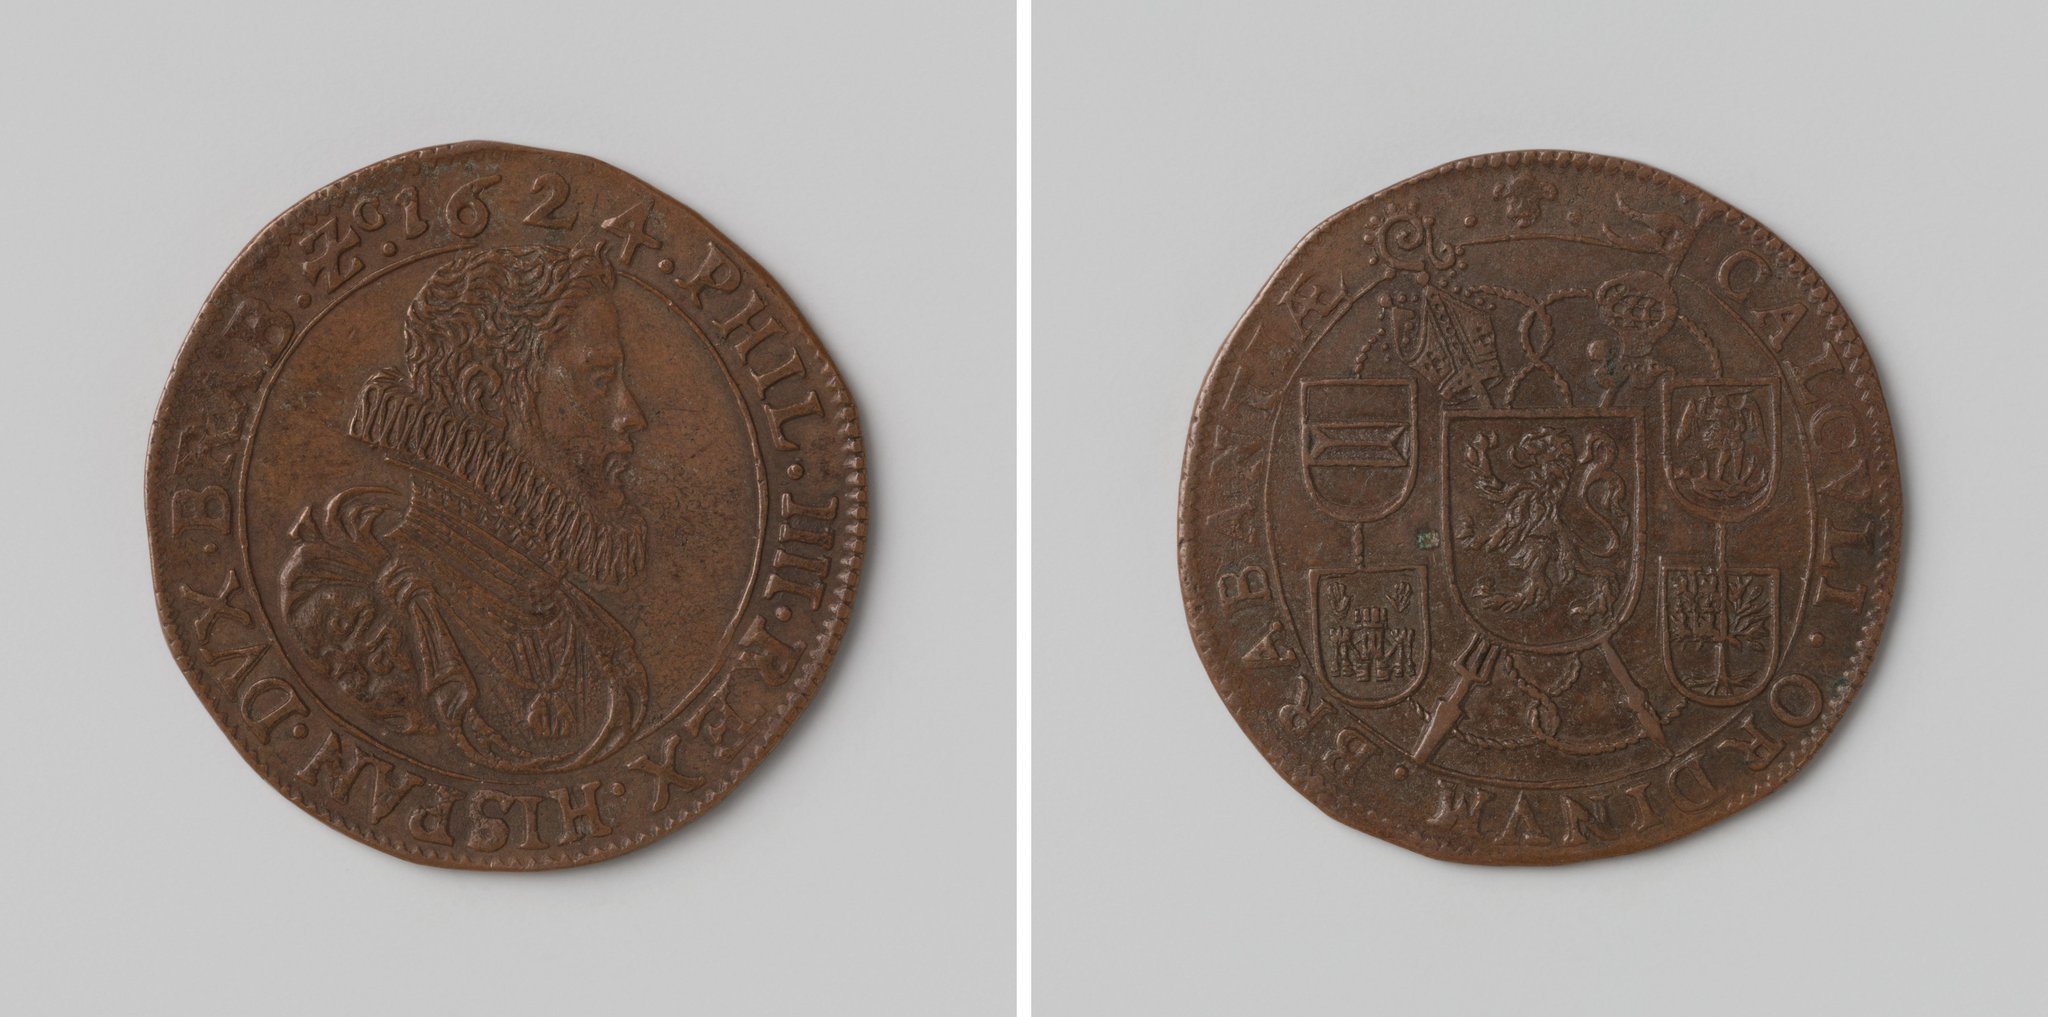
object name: jeton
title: Filips IV, koning van Spanje, rekenpenning geslagen op last van de Staten van Brabant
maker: Anonymous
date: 1624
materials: copper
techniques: striking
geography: brussels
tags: filips iv (koning van spanje), brabant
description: Koperen penning. Voorzijde: borststuk man binnen omschrift. Keerzijde: wapenschild op een gekruiste bisschopsstaf, bekroond met een mijter, en een lans, bekroond met een helm, omgeven door vier met koord samengebonden wapenschilden binnen omschrift